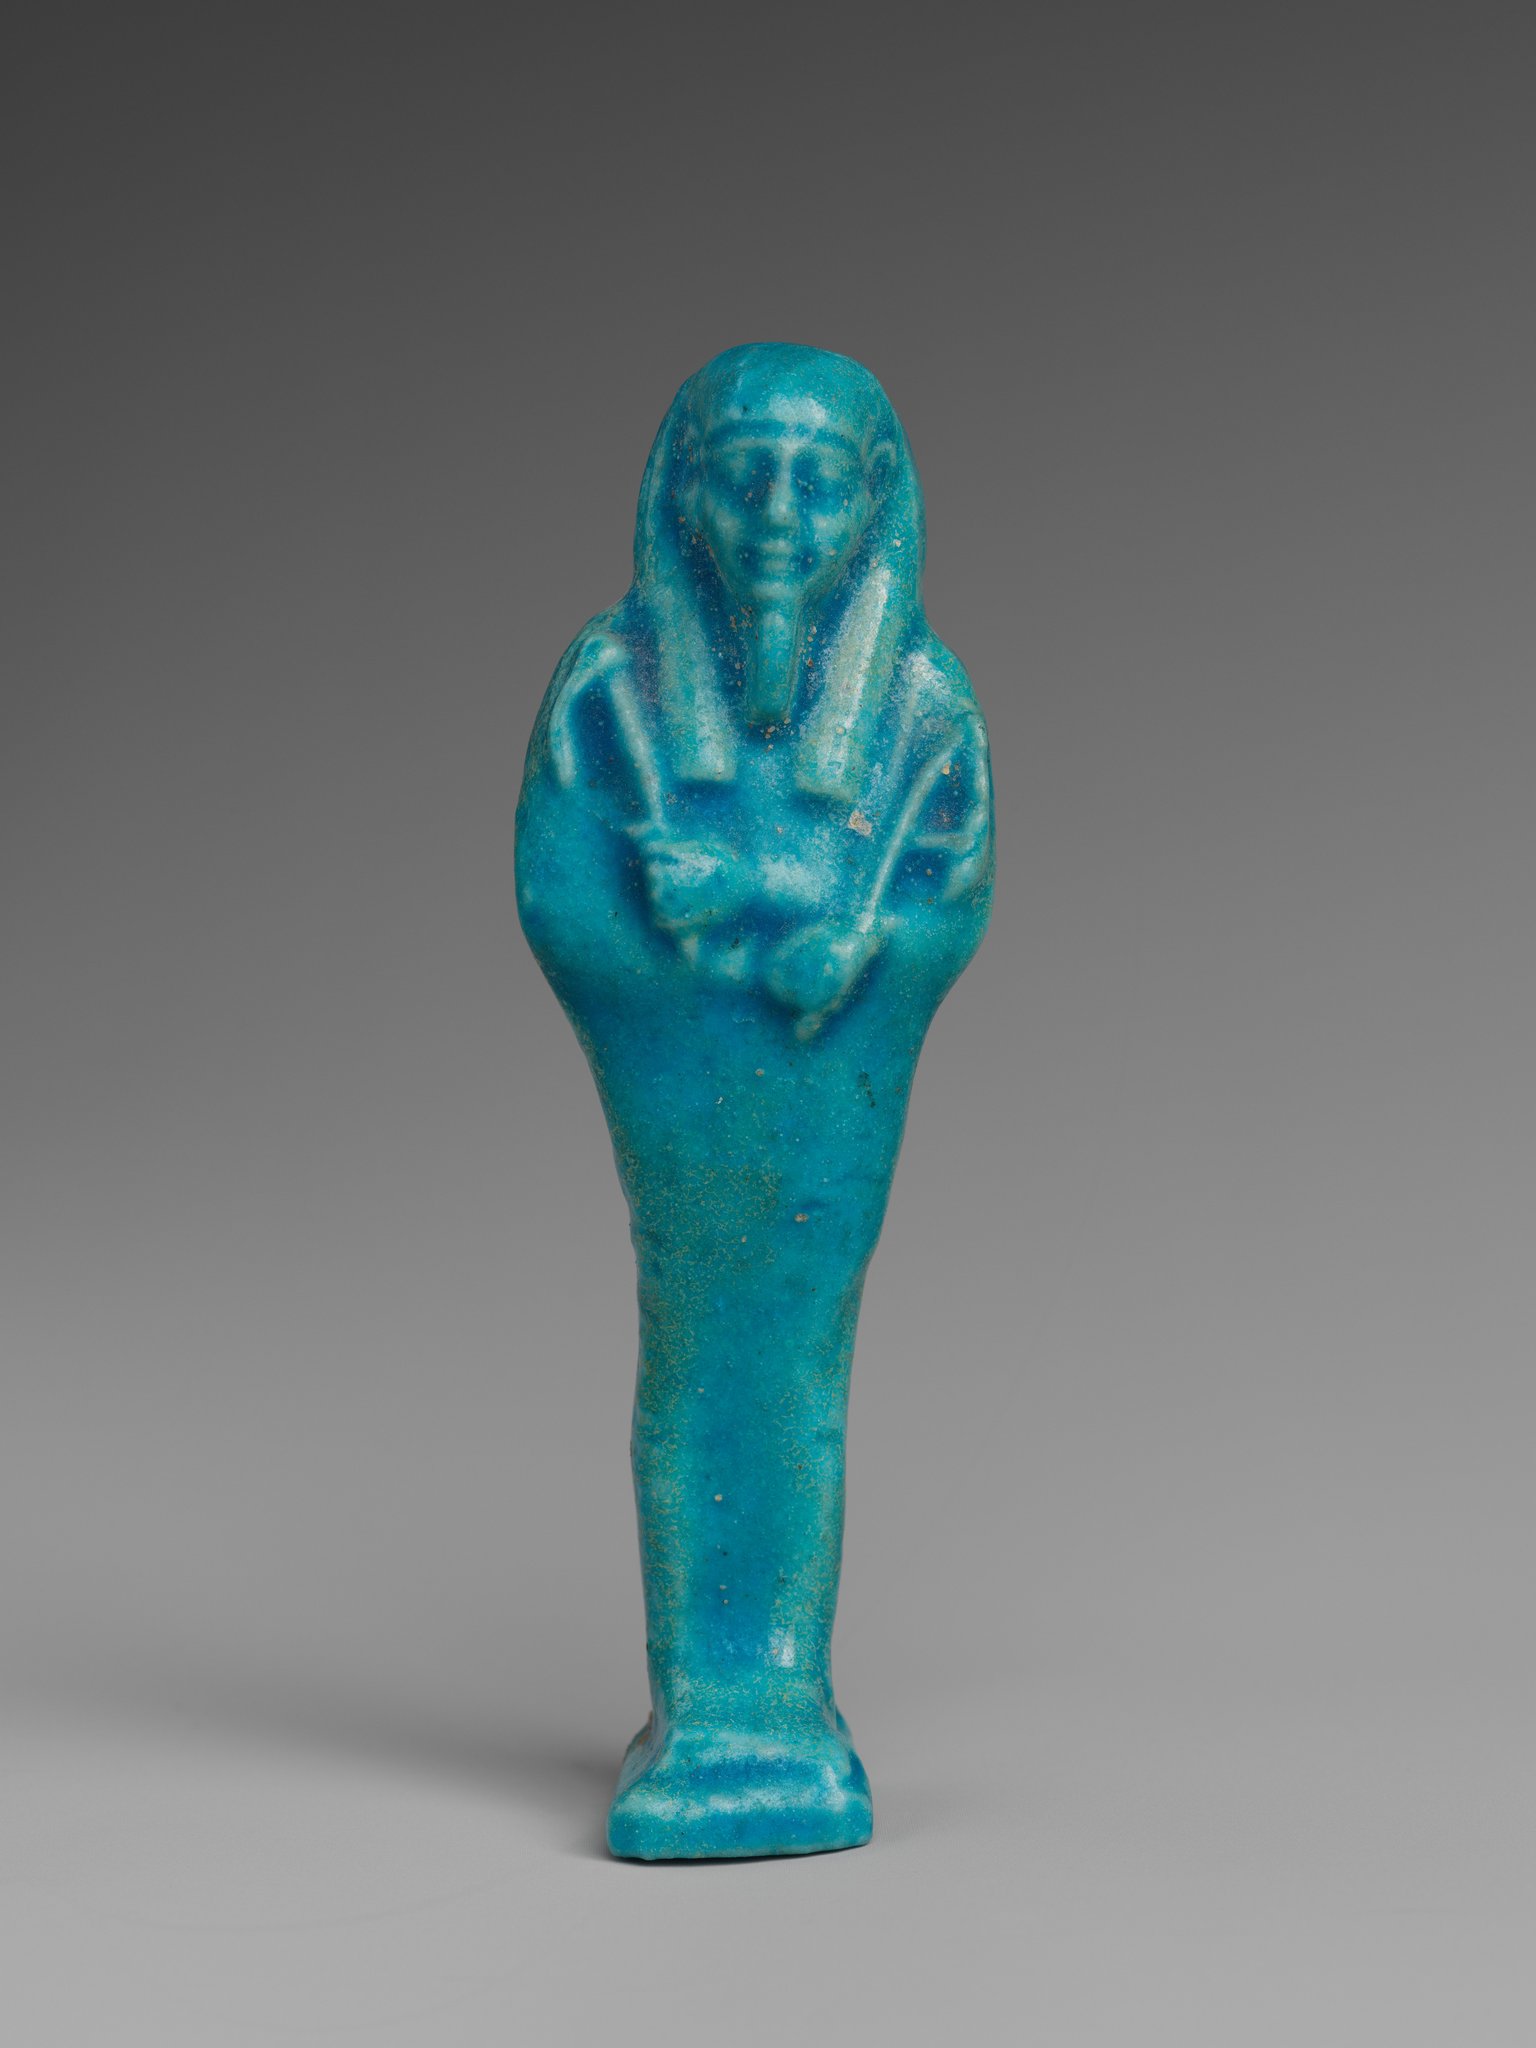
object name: shabti, petosiris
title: Shabti of Petosiris, son of Djedhor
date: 360-300 BCE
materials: faience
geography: egypt